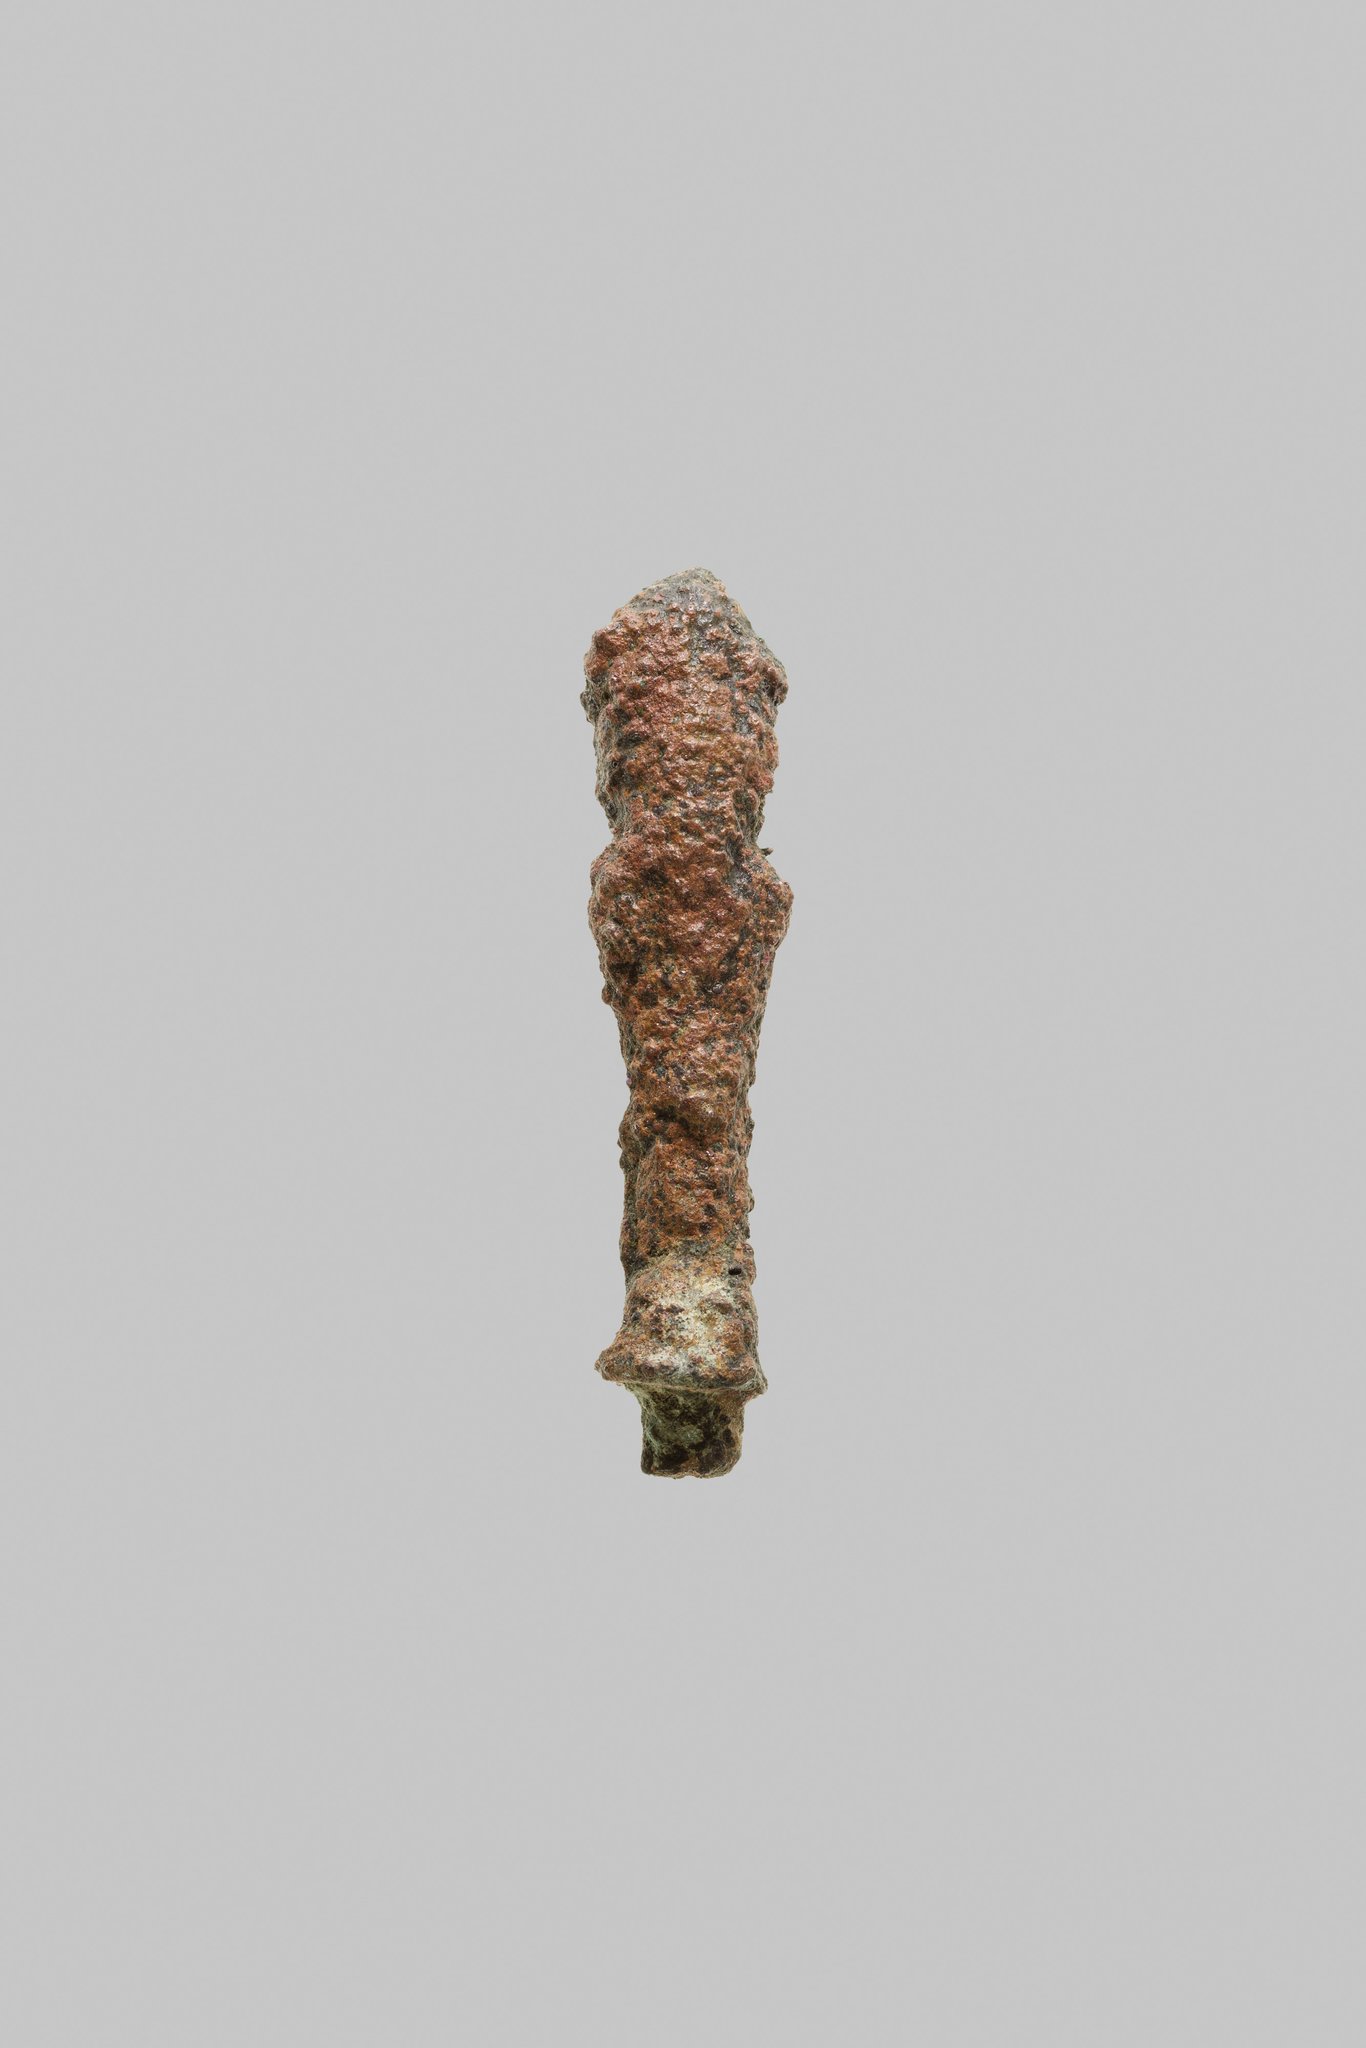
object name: statuette, osiris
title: Statuette of Osiris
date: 712-30 BCE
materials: bronze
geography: egypt